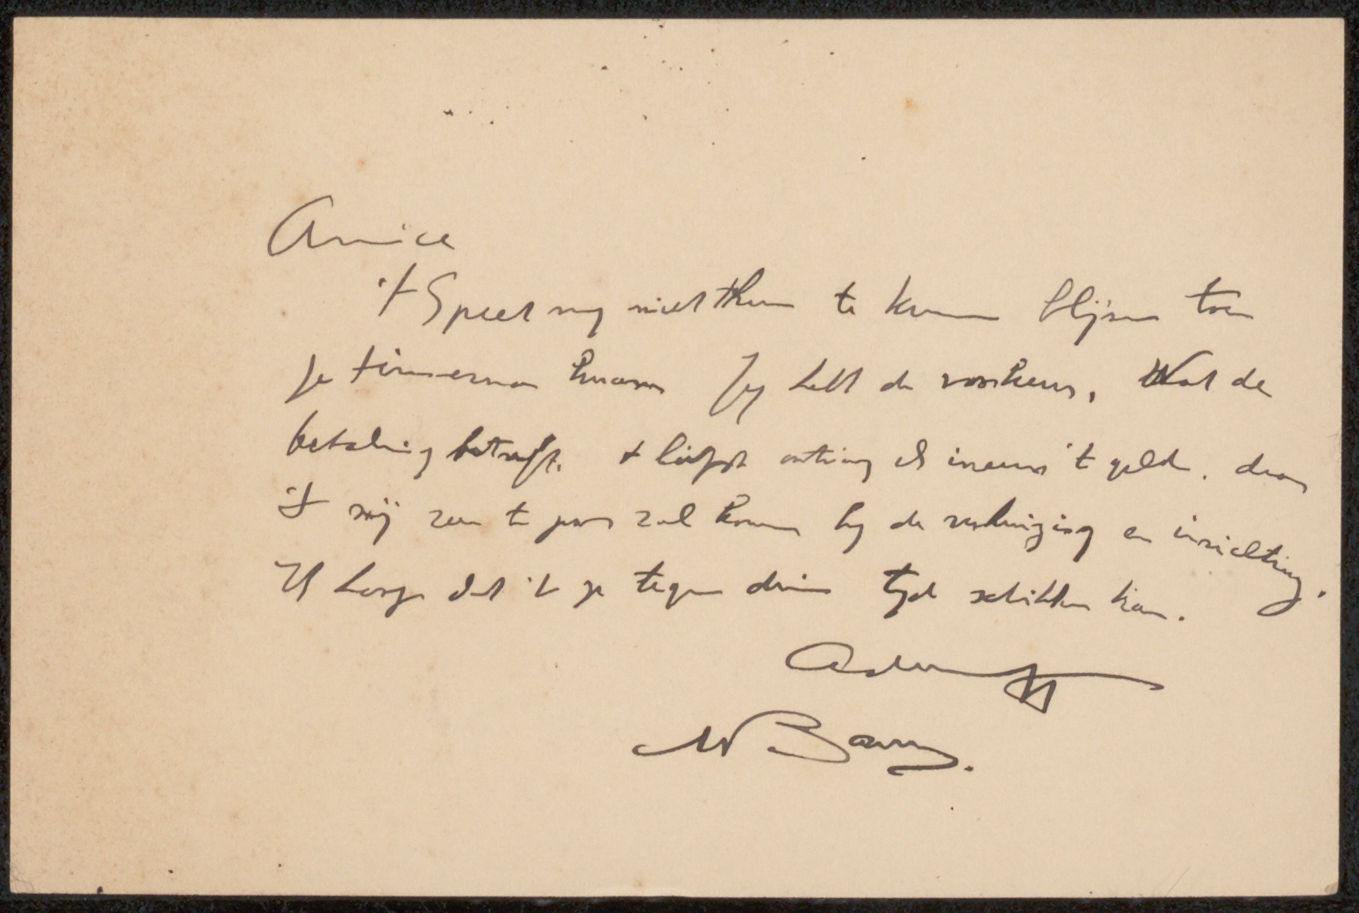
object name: postcard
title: Briefkaart aan Philip Zilcken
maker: marius bauer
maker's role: draughtsman, print maker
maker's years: 1867-1932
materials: cardboard, ink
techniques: pen, writing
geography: the hague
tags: painter, draughtsman, philip zilcken, the hague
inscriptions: collector's mark: ‘RPK’